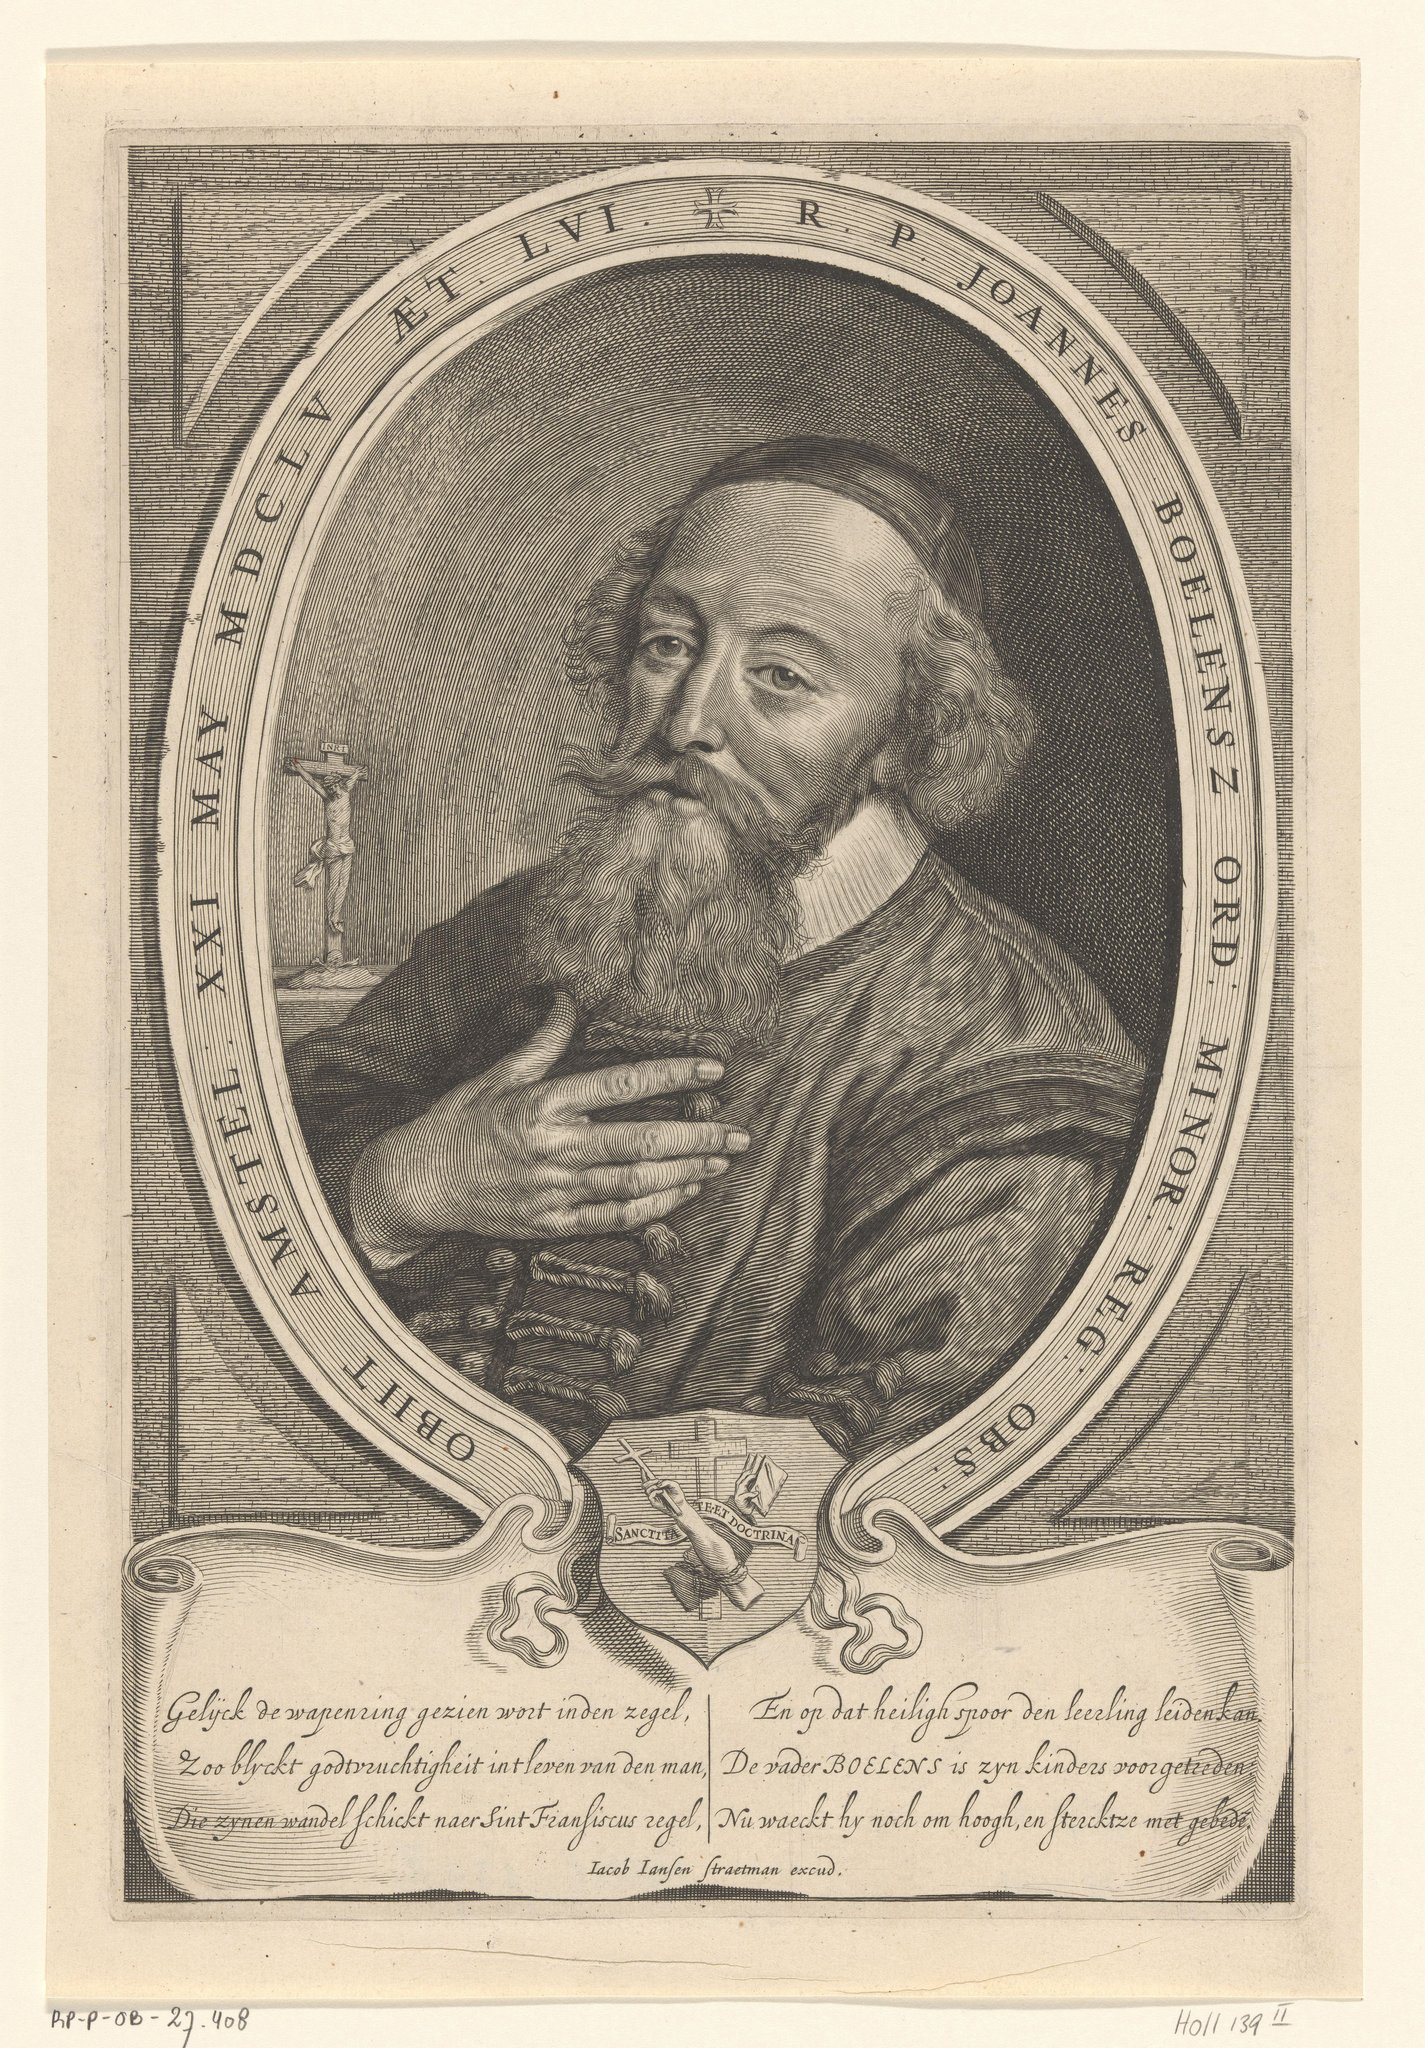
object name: print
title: Portret van Joannes Boelensz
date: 1638-1658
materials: paper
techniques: engraving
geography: amsterdam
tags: crucifix ~ personal devotion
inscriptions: collector's mark: Lugt 240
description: Portret van de Amsterdamse pater franciscaan Joannes Boelensz, met op de achtergrond een crucifix. Hij heeft zijn hand op zijn borst gelegd.